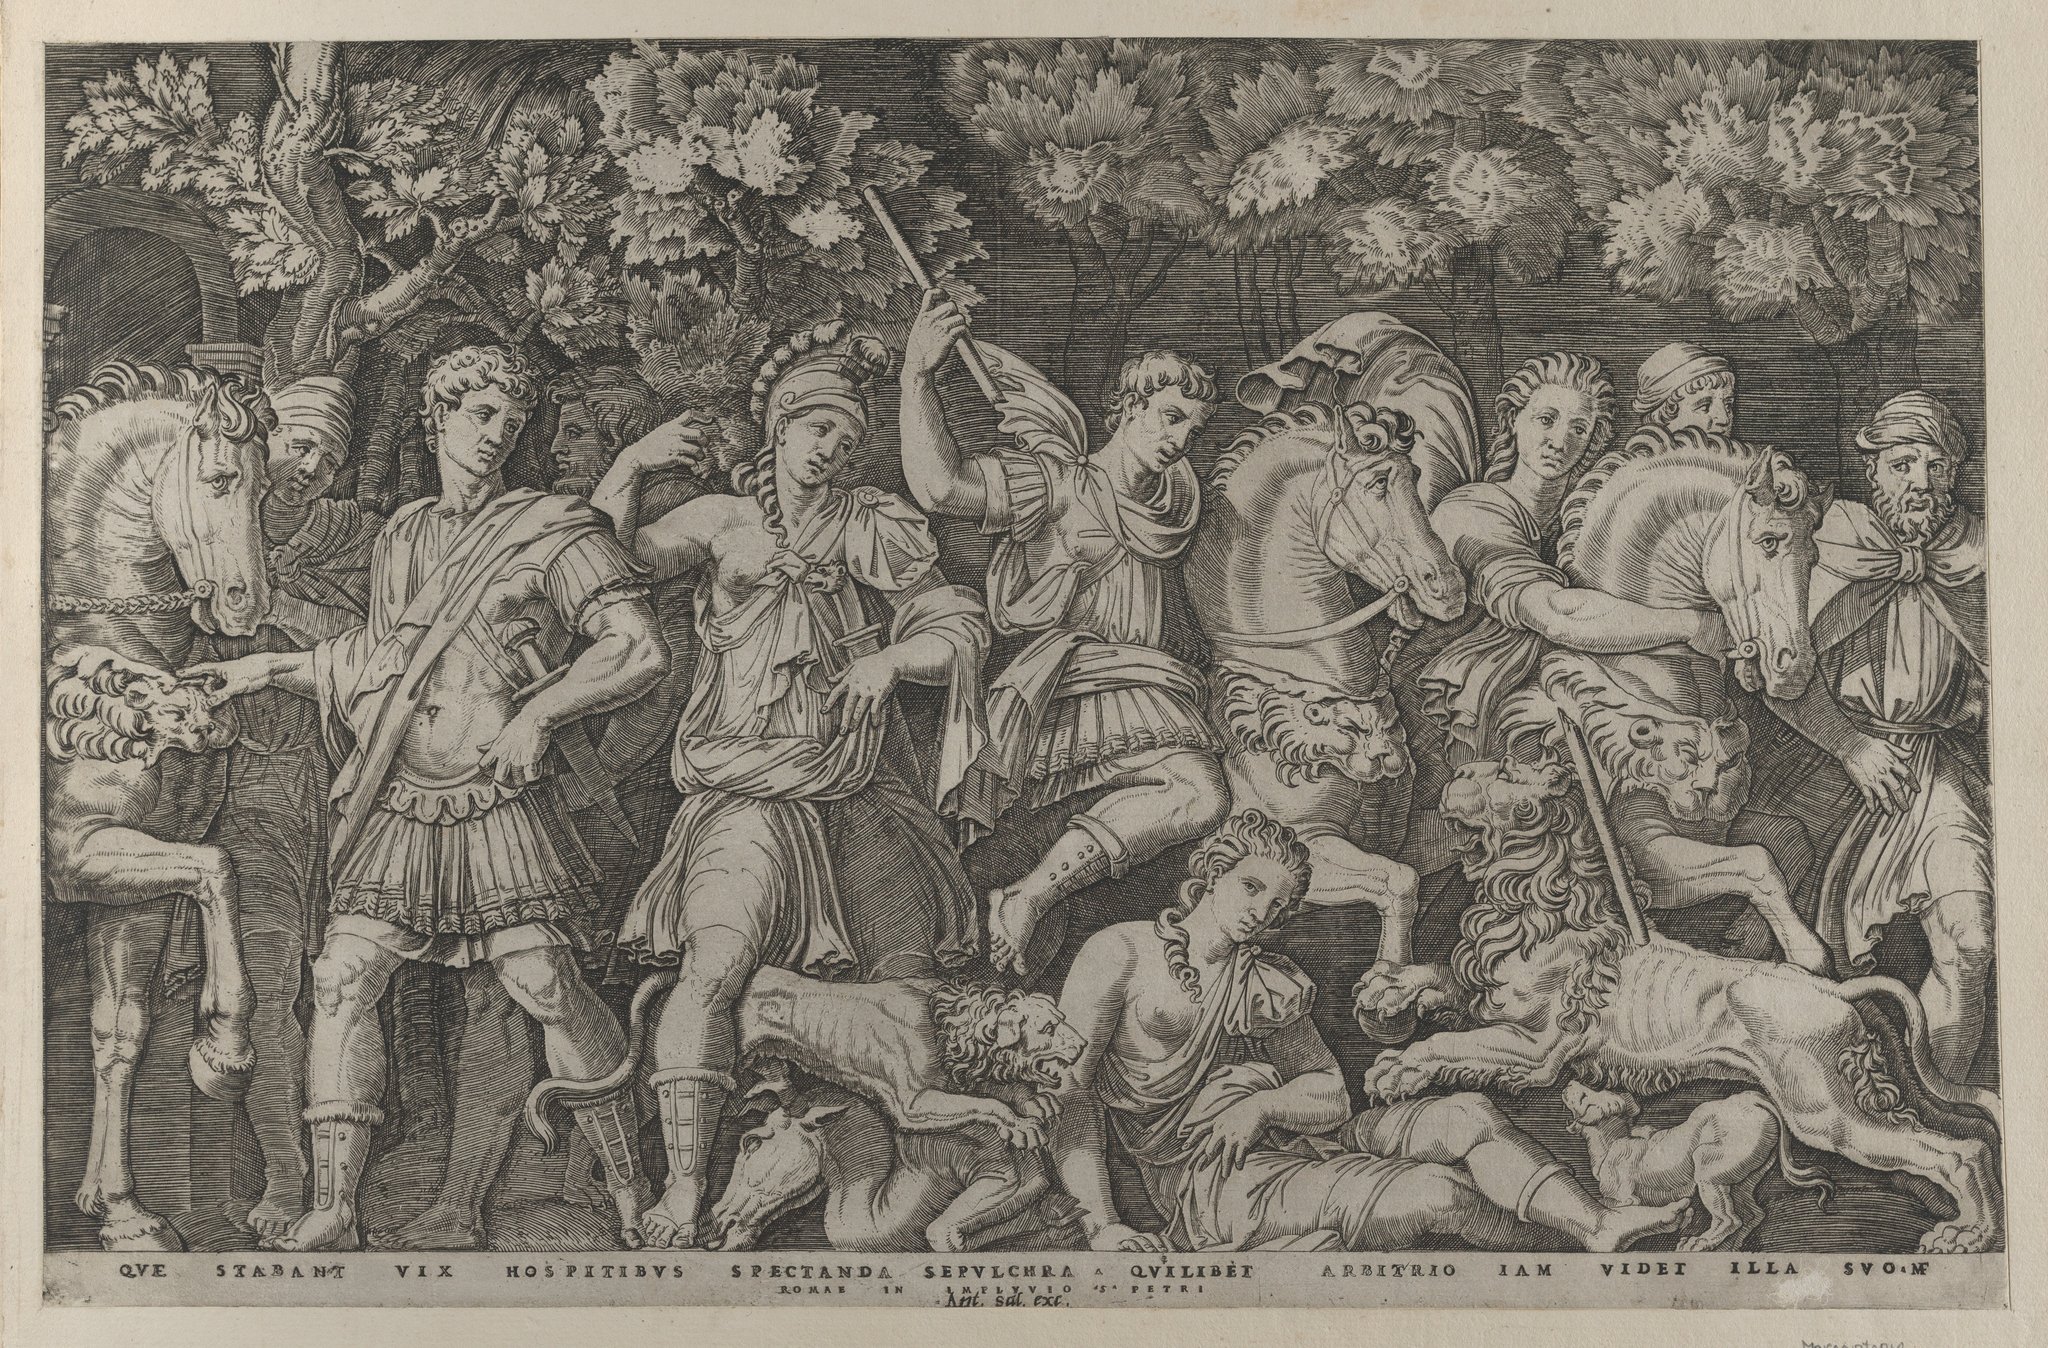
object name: print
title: The Lion Hunt, from "Speculum Romanae Magnificentiae"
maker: marcantonio raimondi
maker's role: artist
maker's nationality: italian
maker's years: 1475-1534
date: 1500-1534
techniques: engraving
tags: men,hunting,horses,lions